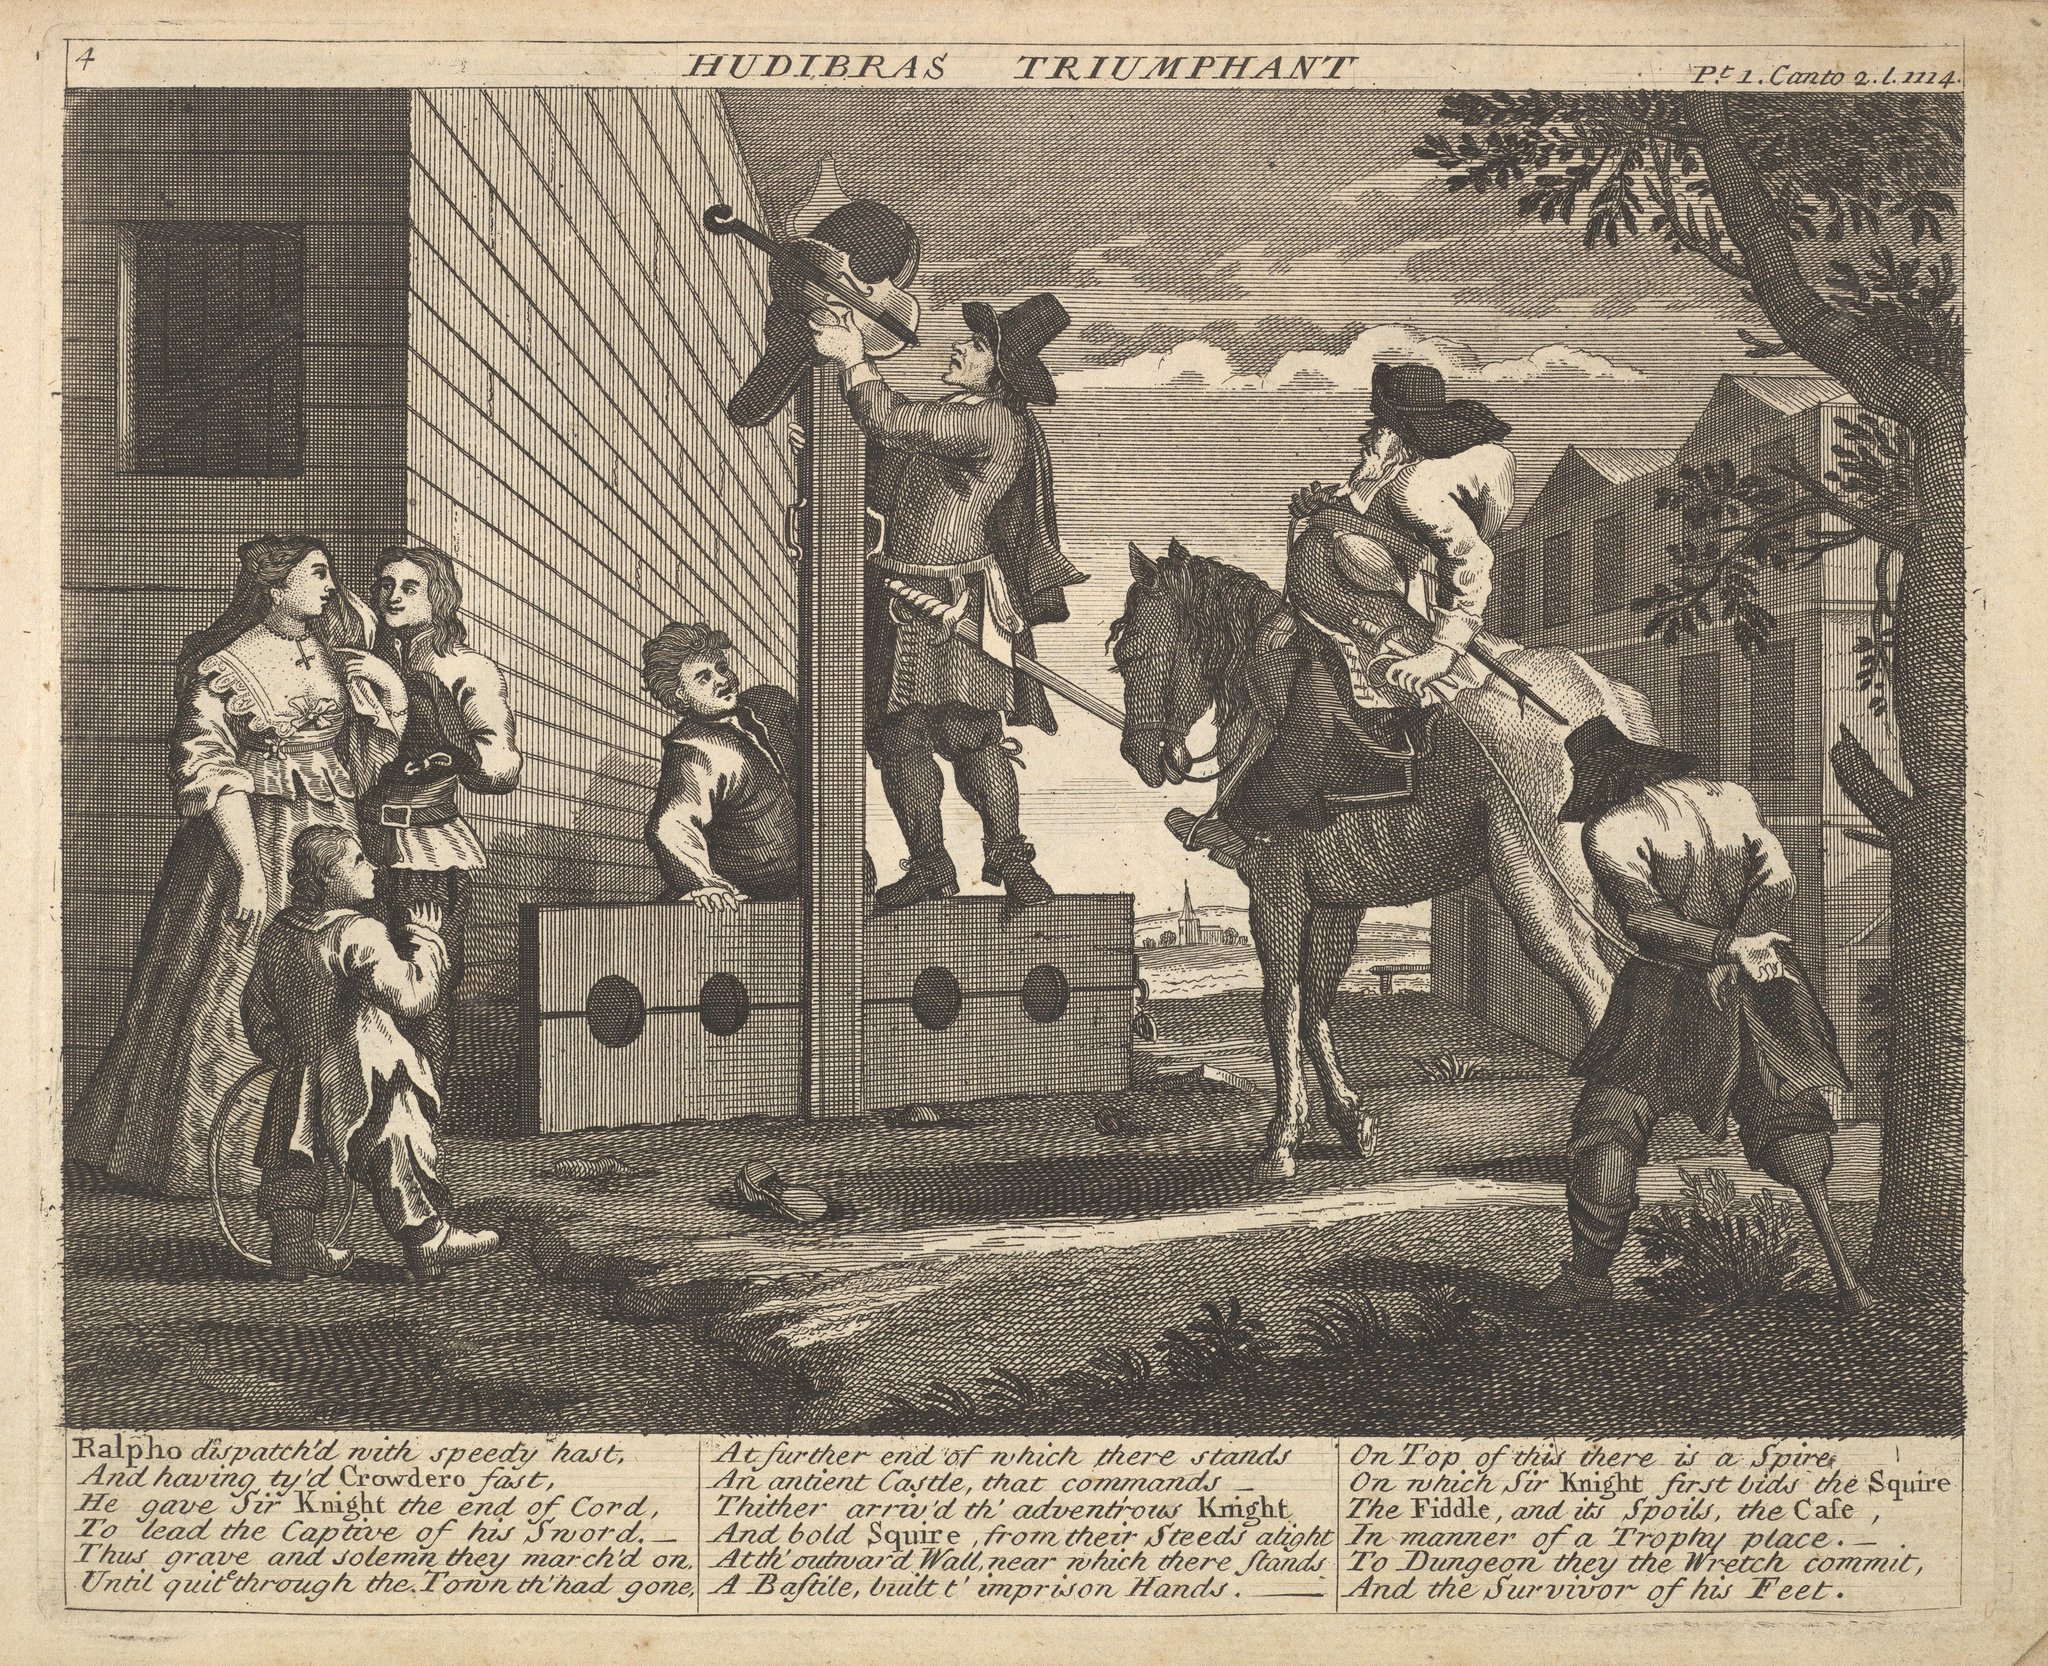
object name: print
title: Hudibras Triumphant (Plate 4: Illustrations to Samuel Butler's Hudibras)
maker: william hogarth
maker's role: artist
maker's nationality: british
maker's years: 1697-1764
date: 1725-1730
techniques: engraving, etching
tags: men,women,violins,horses